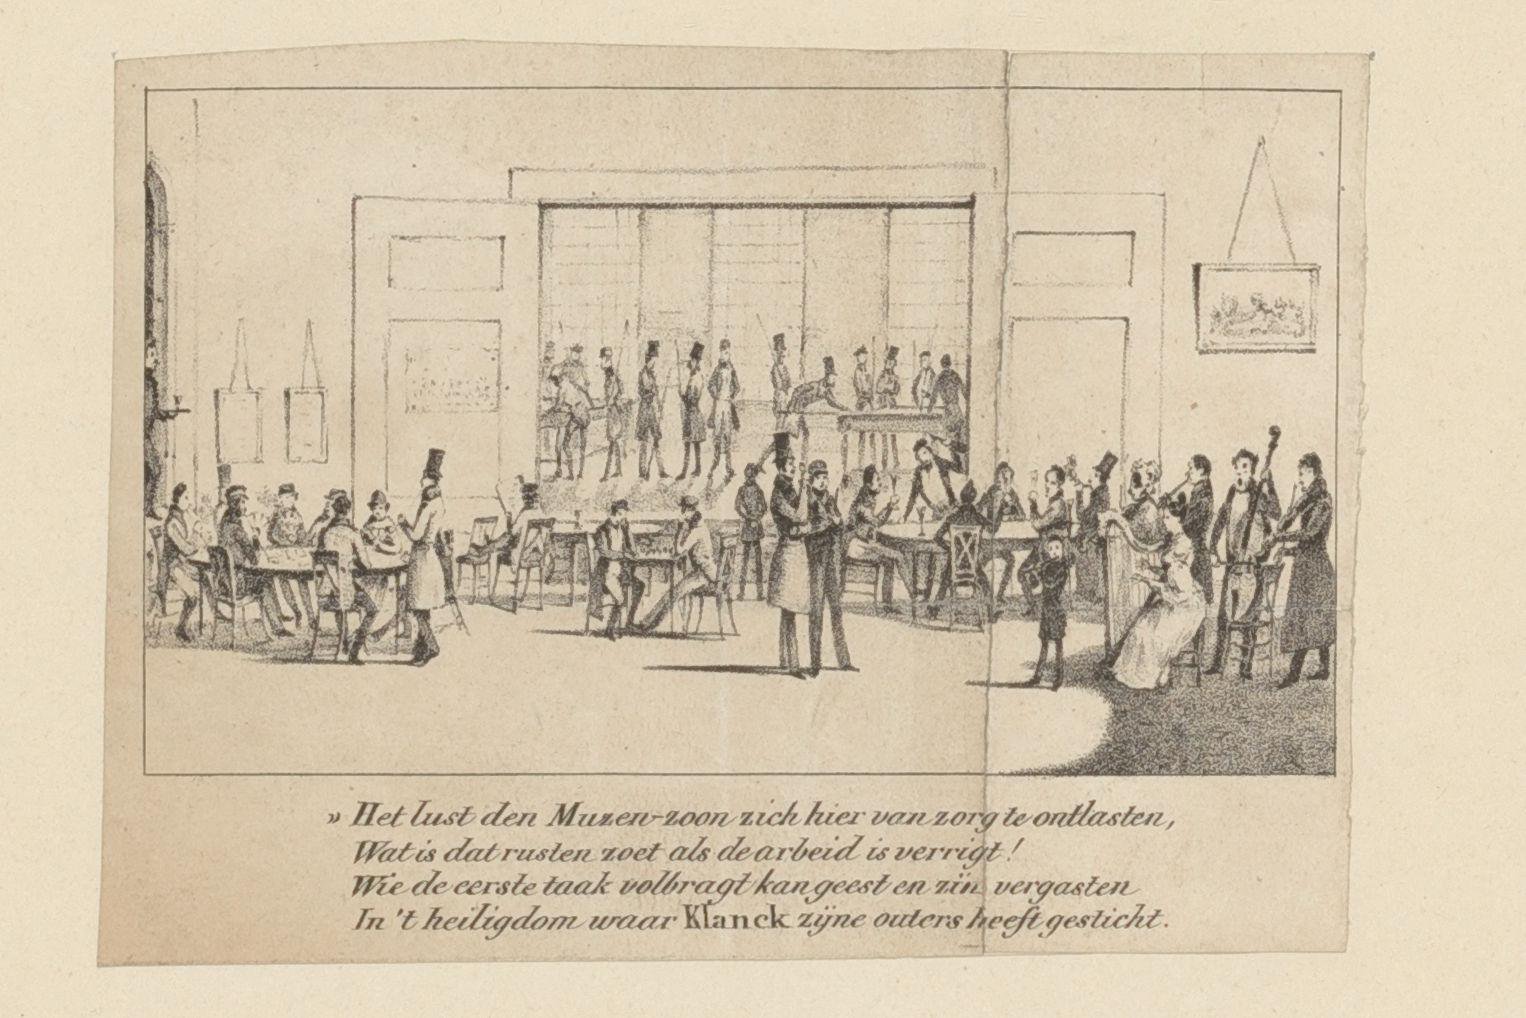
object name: print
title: Zaal waar studenten drinken en spellen spelen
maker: Anonymous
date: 1835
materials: paper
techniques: lithograph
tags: chess, student life, more than one musician with instrument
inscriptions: collector's mark: Lugt 1641, stamp, stamp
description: Prent mogelijk geknipt uit een grotere prent met de titel op object: Stichtsche School-prent. Prent gepubliceerd bij: Utrechtsche Studenten almanak. Utrecht: J. van Druten, 1885.